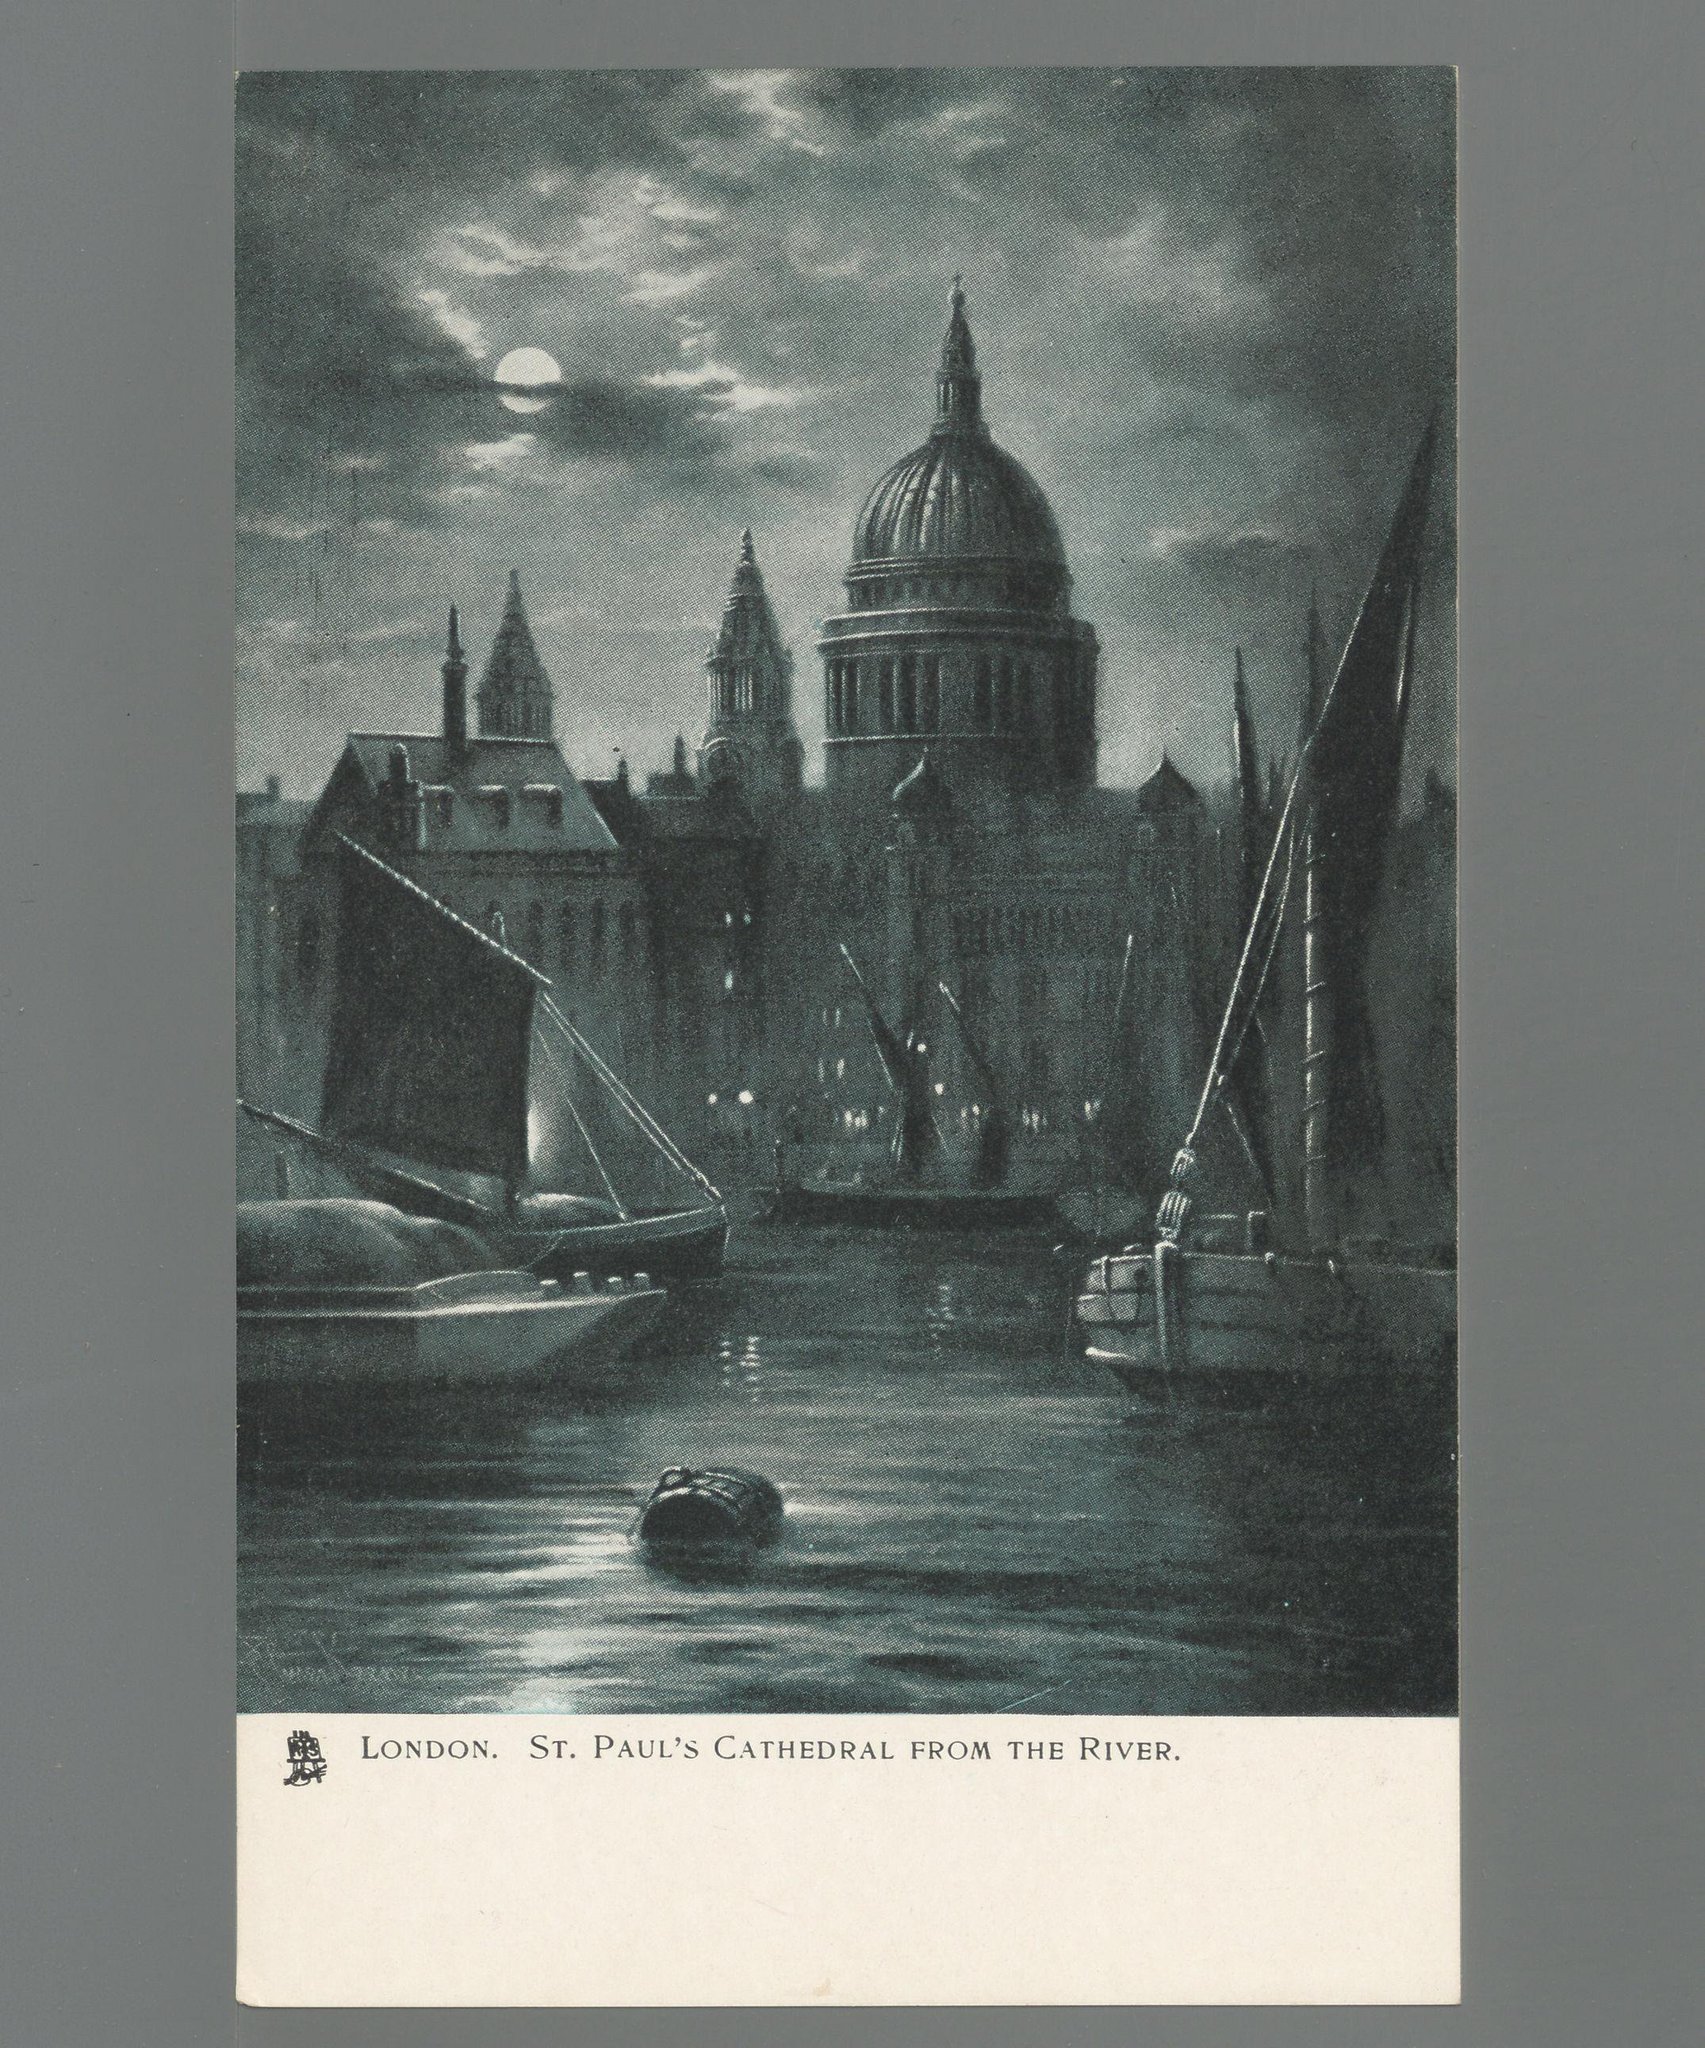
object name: reproduction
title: London. St. Paul's Cathedral from the River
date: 1903-1909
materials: cardboard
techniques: autotype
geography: england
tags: church (exterior), canals, waters (in city), thames